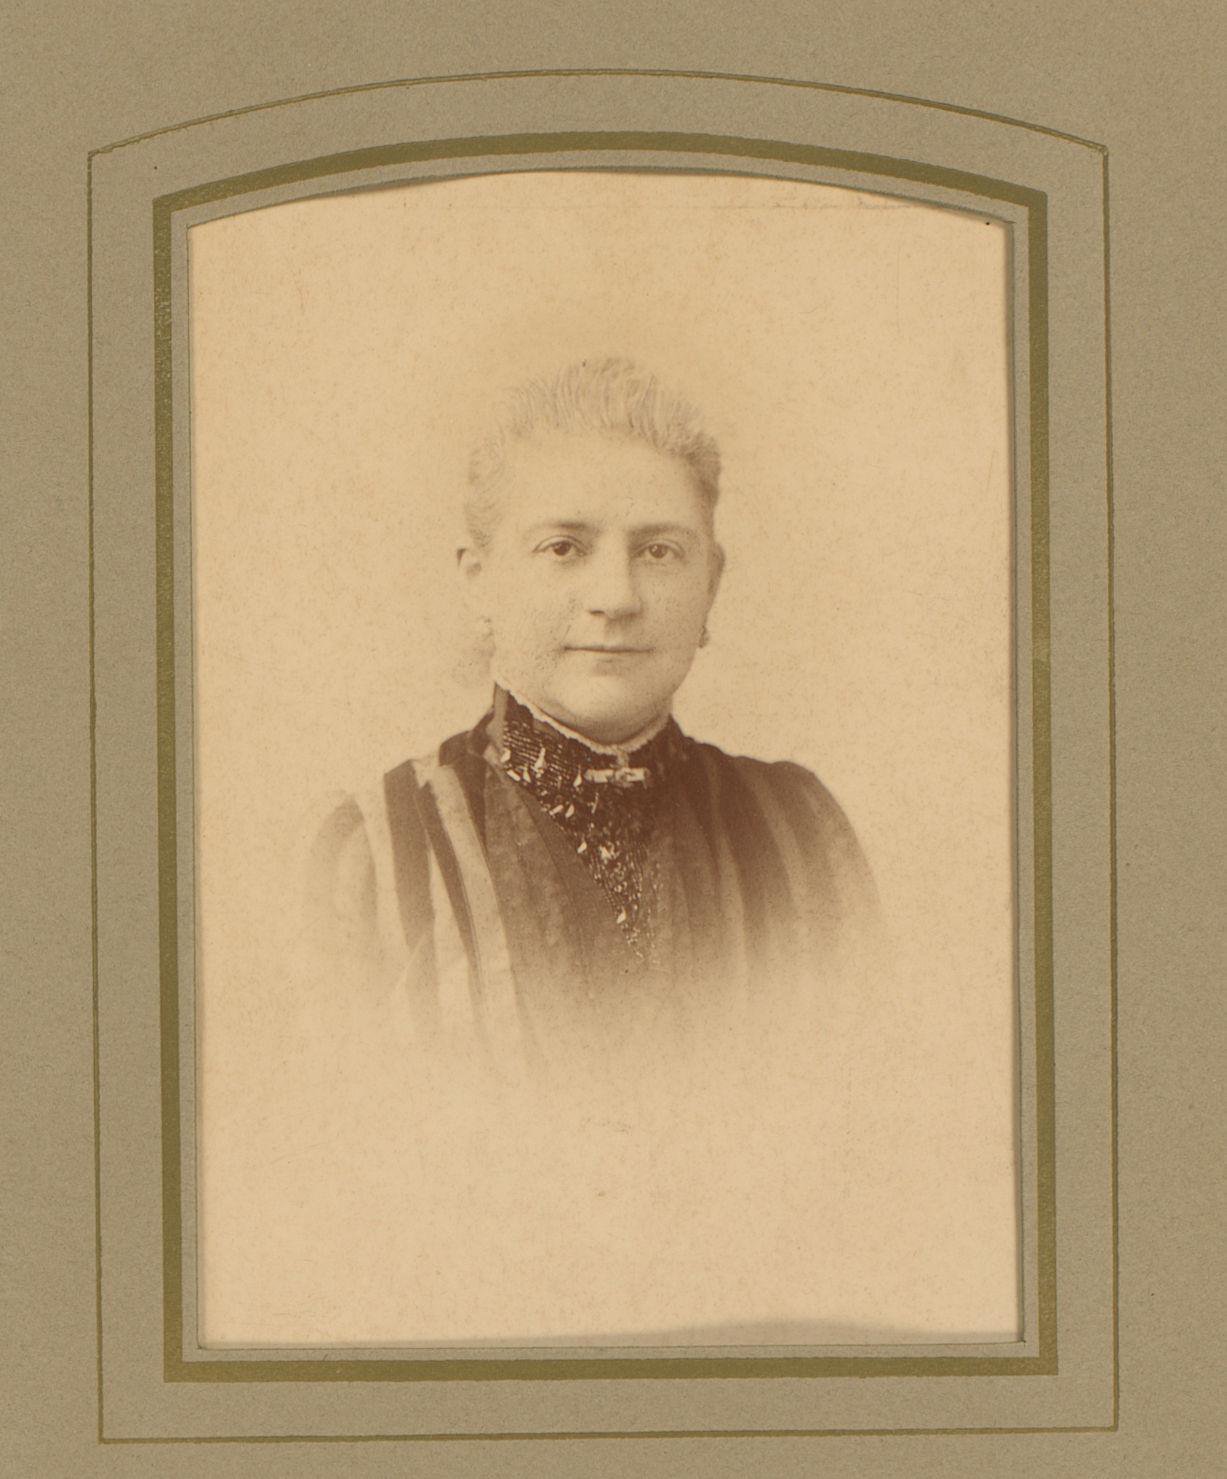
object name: photograph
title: Portret van een vrouw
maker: max büttinghausen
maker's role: fotograaf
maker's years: 1847-1906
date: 1873-1906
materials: cardboard, photographic support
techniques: albumen print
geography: amsterdam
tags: historical persons - bb - woman